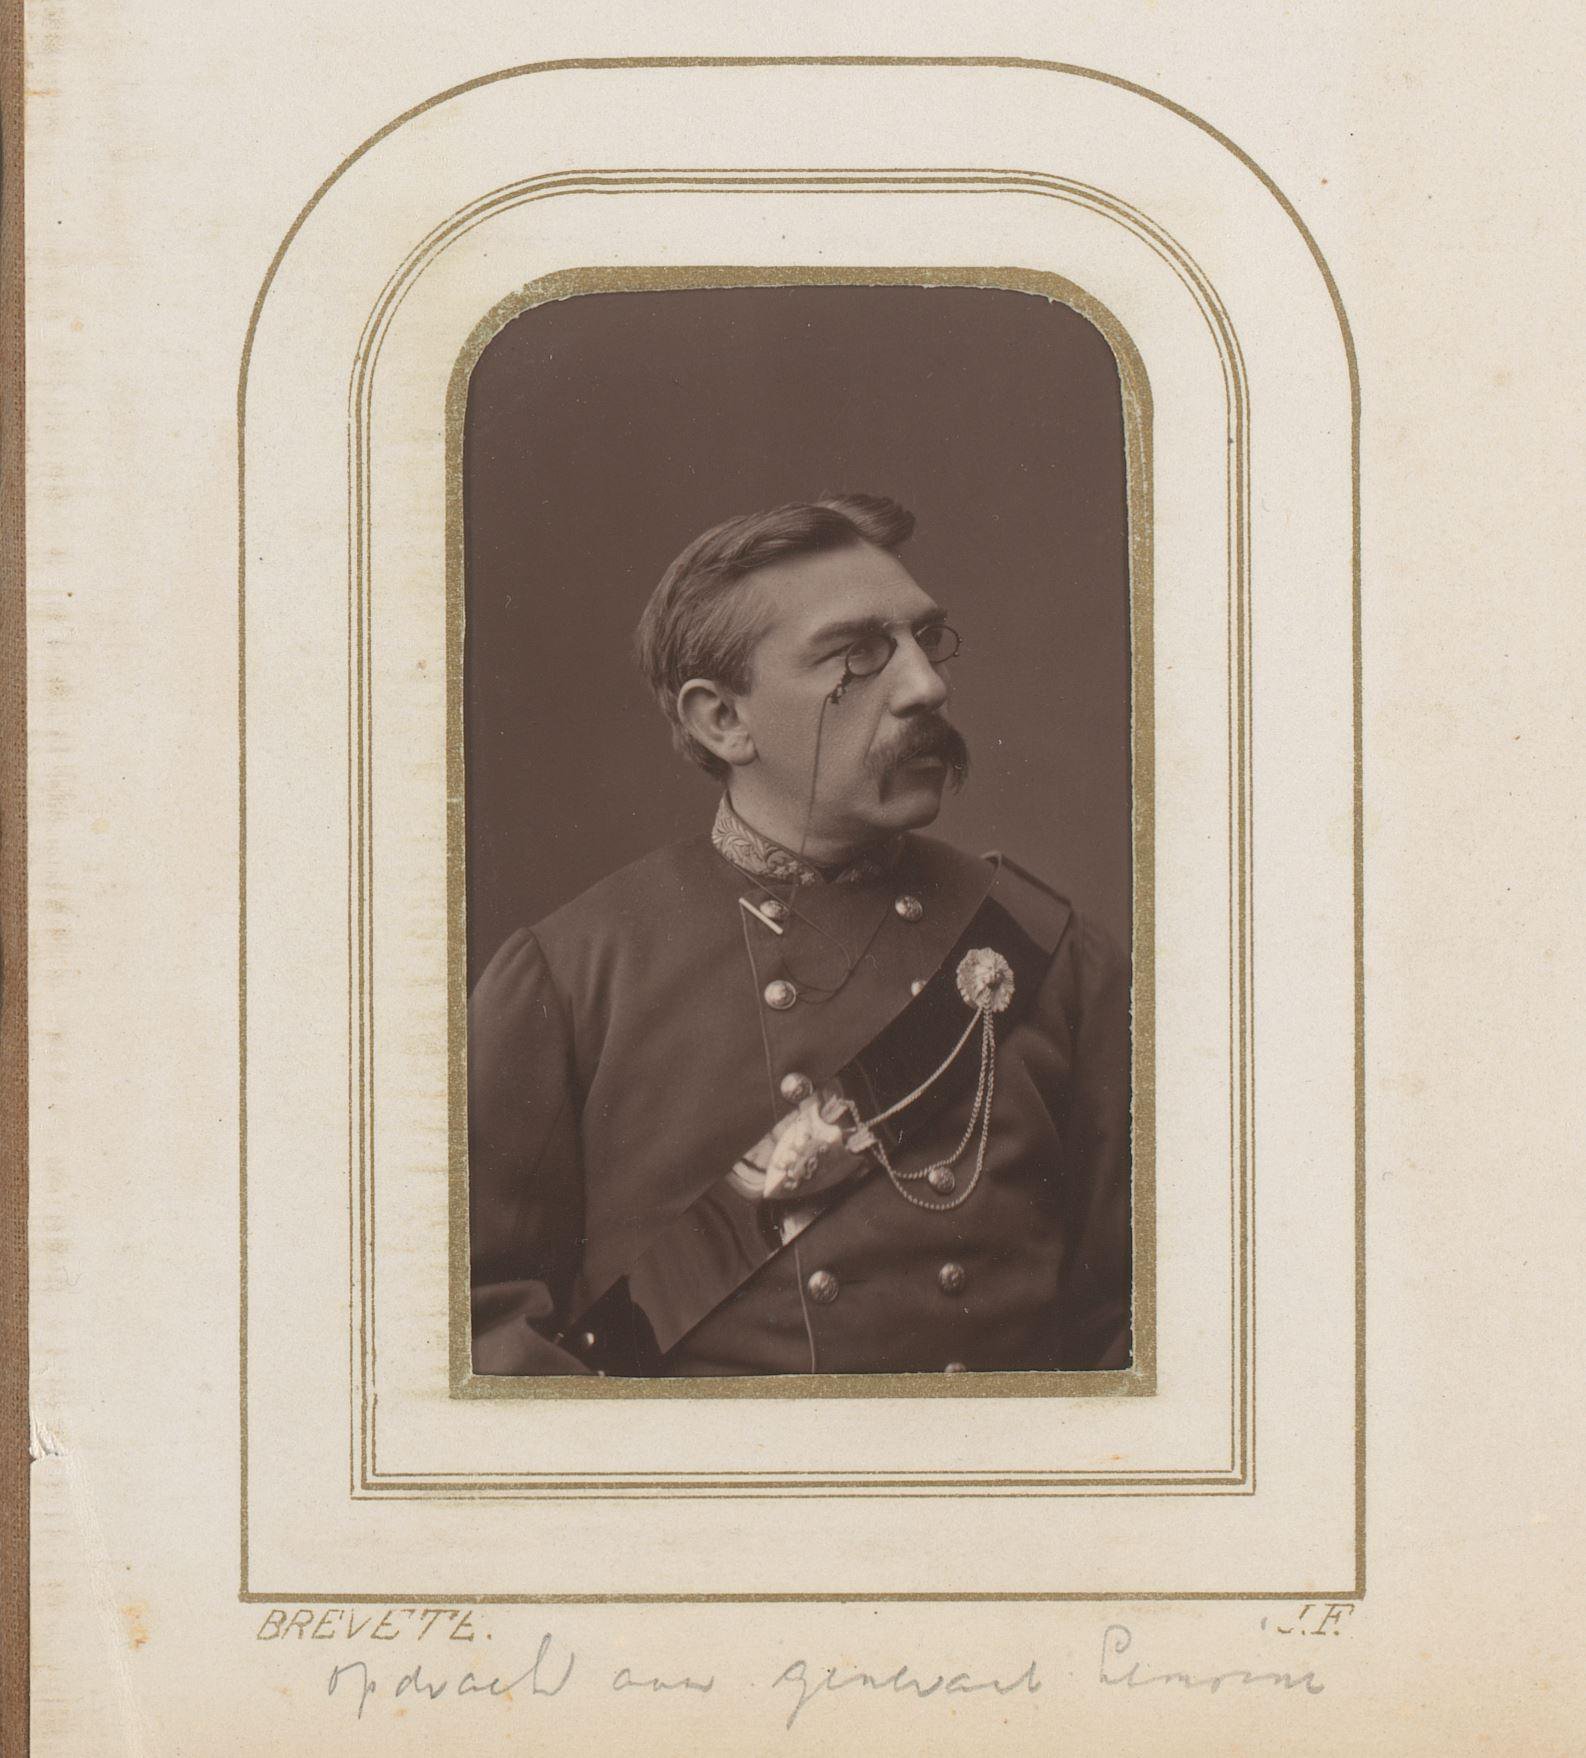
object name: photograph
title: Portret van een man in uniform met bril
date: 1882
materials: cardboard, photographic support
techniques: carbon print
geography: brussels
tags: eyeglasses, spectacles, historical persons, (military) uniforms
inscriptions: inscription: ‘Photograph au charbon/ Géruzet Frères/ Photographes de S.M. la Reine des Belges/ 27b Rue de l'Ecuyer/ Bruxelles’, annotation: ‘A mon cher général/ Lemoine!/ Souvenir de haute/ estime et l'amitié sincère/ Mars 1882/ [...]’, annotation: ‘opdracht aan generaal Lemoine’